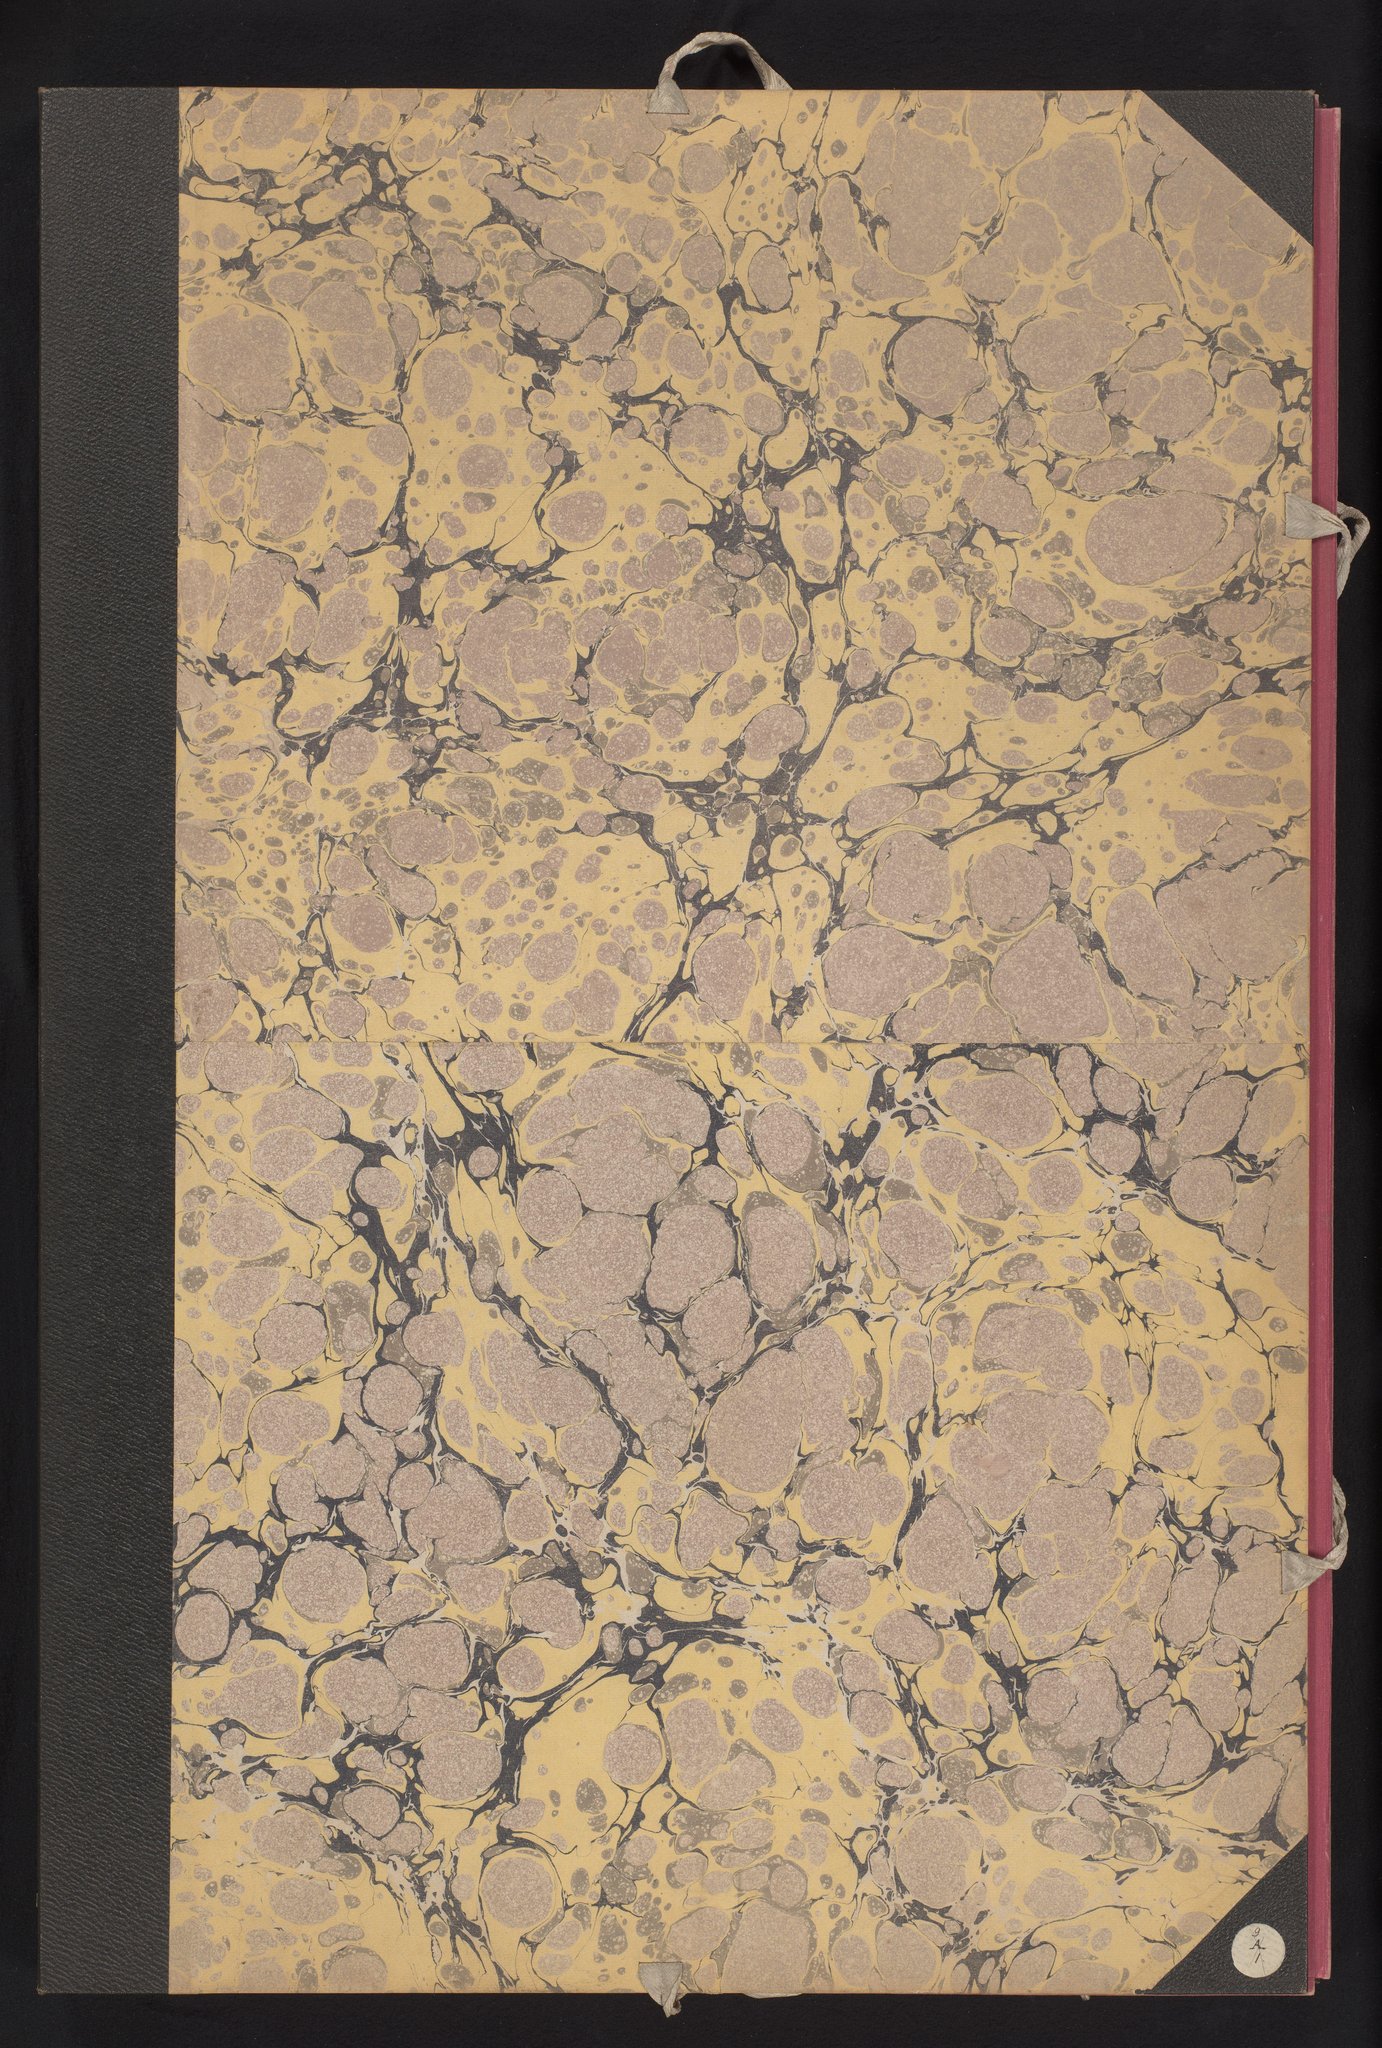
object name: folder container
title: Jackson. Aims and Ideals of Great Britain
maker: Anonymous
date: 1912-1917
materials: cardboard, leather, paper, ribbon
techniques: decorated paper, marbling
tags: war and peace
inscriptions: collector's mark: Lugt 2166, watermark, collector's mark: Lugt 2166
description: Ondanks dat de naam 'Jackson' op deze omslag staat, zijn de meest prenten niet vervaardigd door deze kunstenaar. In 1917, na drie jaar oorlogsvoering, had de regering een nieuwe manier nodig om de publieke steun voor de oorlog te behouden. De 66 prenten in de serie 'The Great War: Britain’s Efforts and Ideals' zijn gemaakt in opdracht van Wellington House, een Britse overheidsdienst die was opgericht om propaganda te produceren. De prenten werden gemaakt met het specifieke doel het moreel besef van de burger te verhogen en de publieke opinie over de Eerste Wereldoorlog in Groot-Brittannië (en in het buitenland) te manipuleren. Deze prenten zijn ontworpen om mensen te herinneren aan het hogere doel en om de patriottische plicht te benadrukken. Het project werd geleid door de kunstenaar Thomas Derrick (1885–1954) en het drukken werd uitgevoerd onder leiding van de kunstenaar Francis Ernest Jackson (1872-1945). De drukker was Avenue Press in Londen. De Britse overheid stelde dat de kunstenaars voor deze opdracht geen volledige artistieke vrijheid kregen: ze kregen onderwerpen toebedeeld en de prenten moesten worden 'goedgekeurd'. De serie prenten zijn onderverdeeld in de delen: 'Ideals', 'Making Soldiers', 'Making Sailors', 'Making Guns', 'Building Ships', 'Building Aircraft', 'Work on the Land', 'Tending the Wounded', 'Women's work' en 'Transport by Sea'. Ze werden voor het eerst tentoongesteld in de Fine Art Society in Londen in juli 1917, en werden daarna geëxposeerd in regionale kunstgalerijen in Groot-Brittannië.